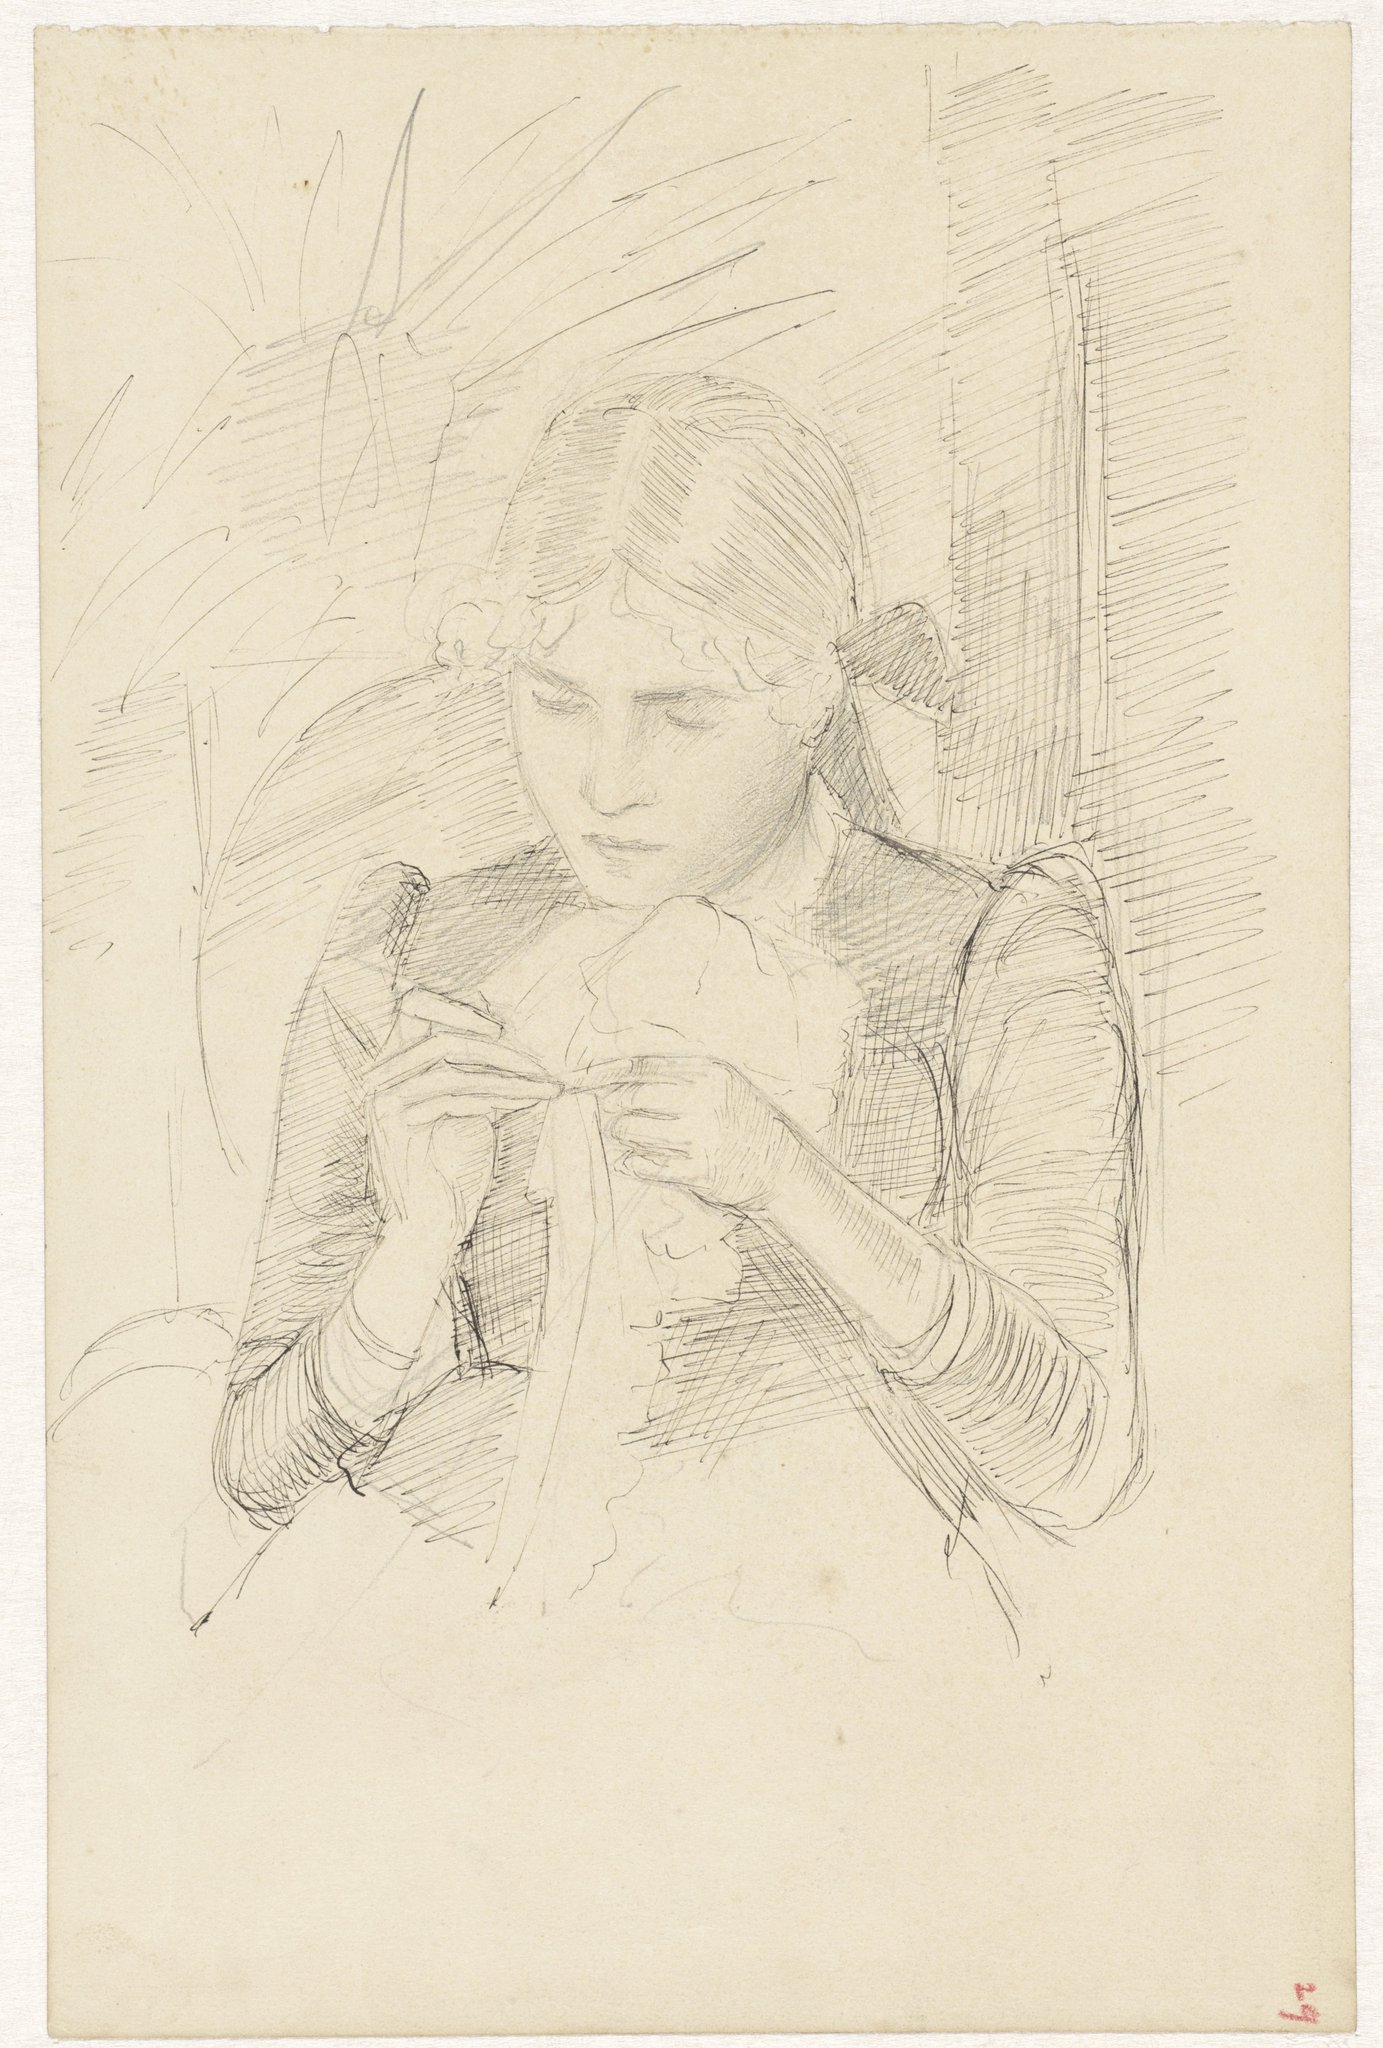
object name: drawing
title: Handwerkende vrouw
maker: jozef israëls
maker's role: draughtsman, painter, print maker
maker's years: 1824-1911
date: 1834-1911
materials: ink, paper, pencil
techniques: pen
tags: (other forms of) needlework, e.g.: crocheting, knitting, embroidering